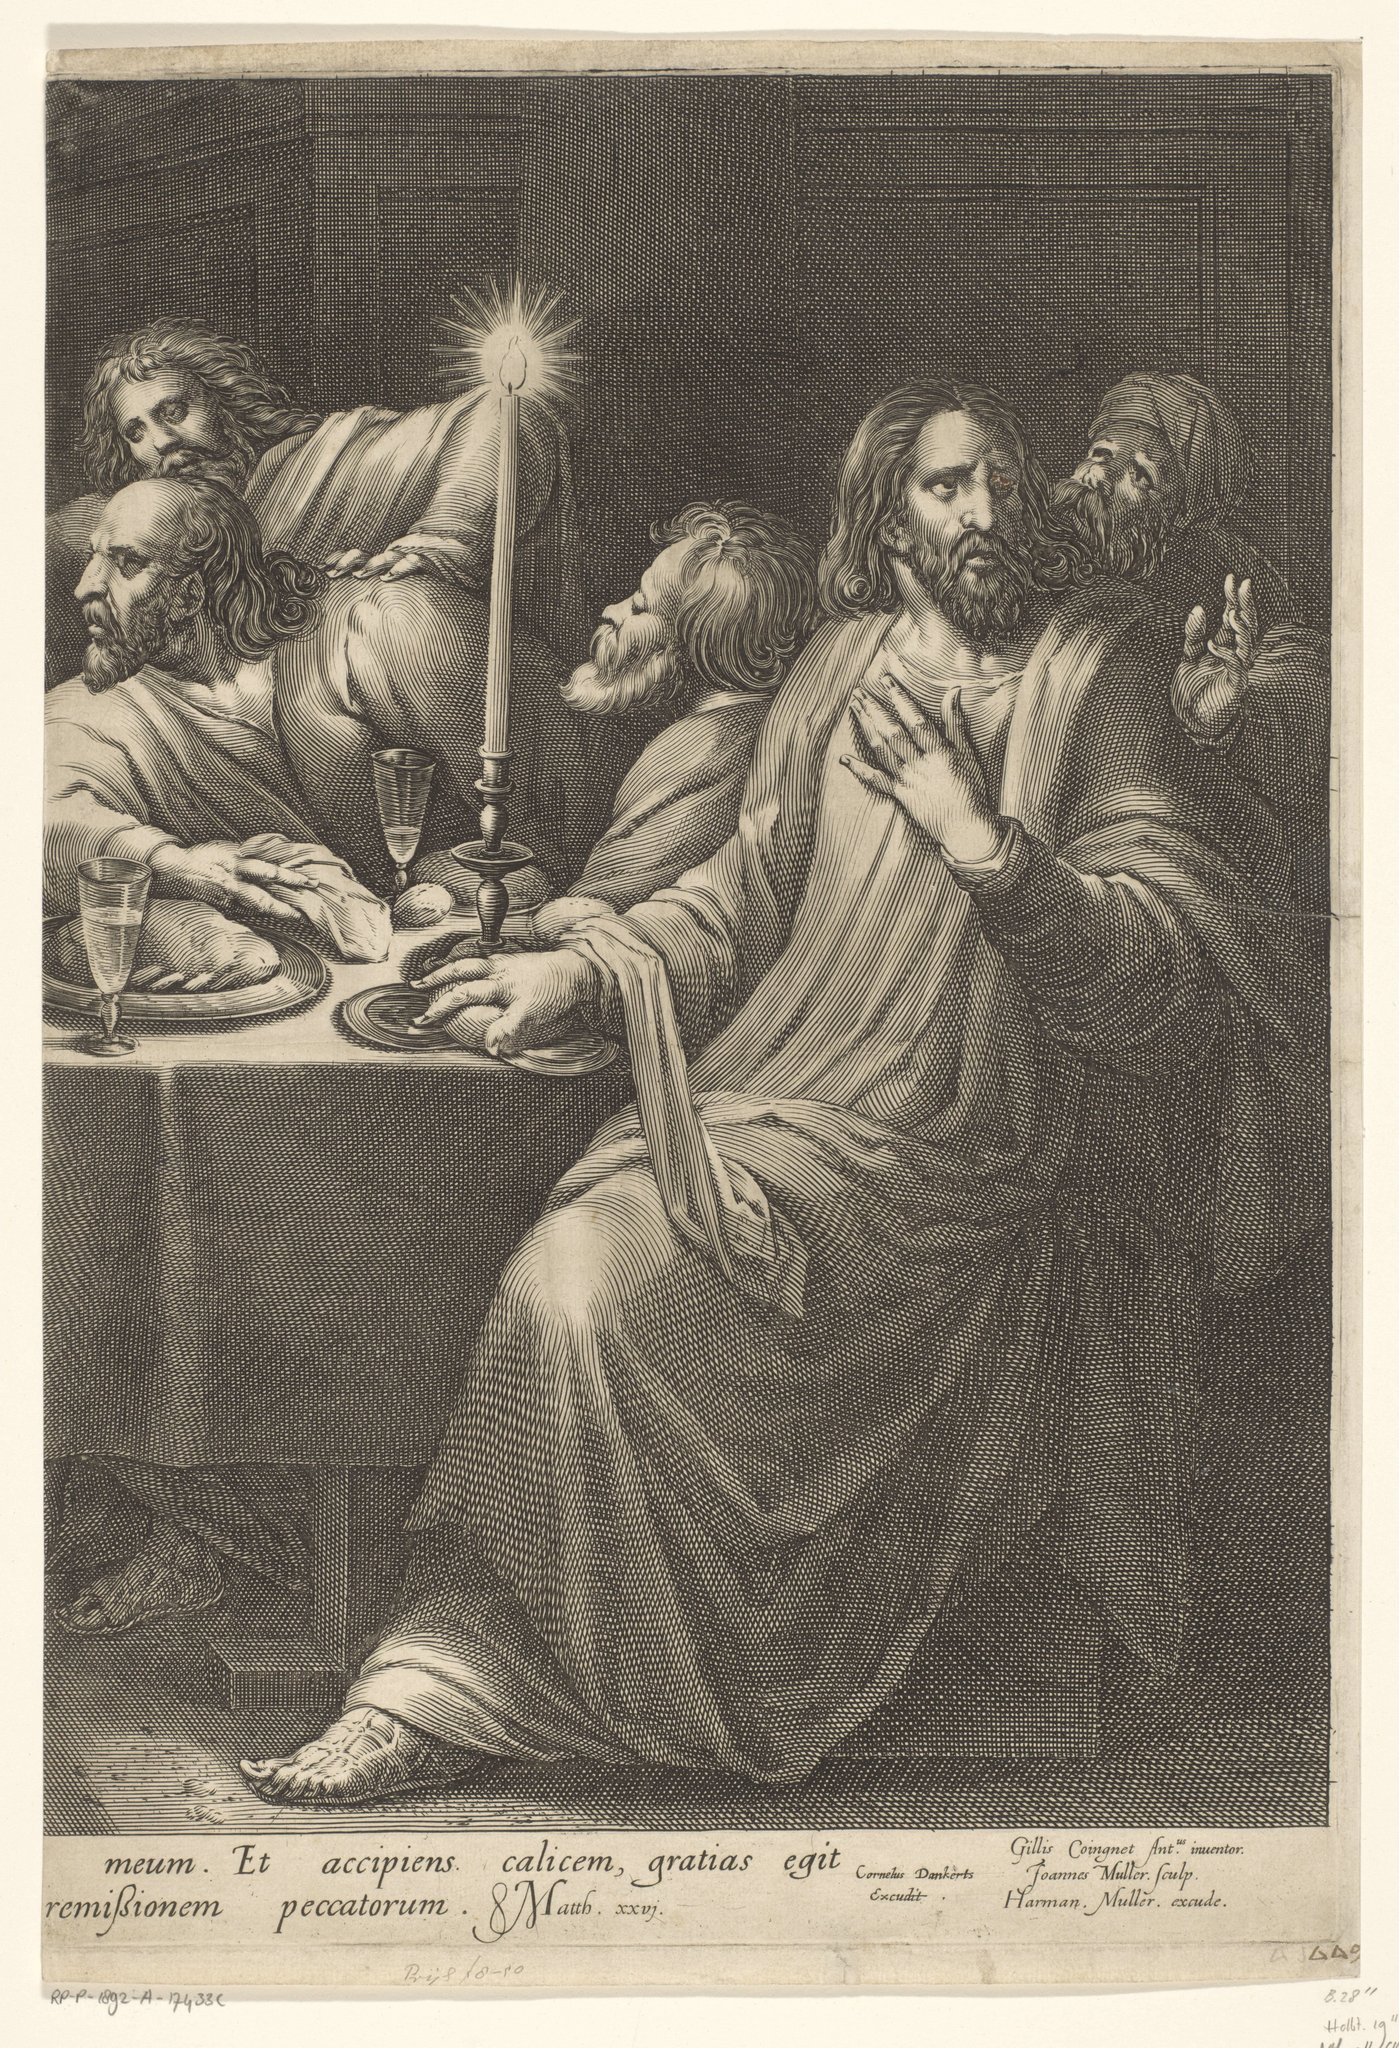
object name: print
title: Laatste avondmaal (rechter blad)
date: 1594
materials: paper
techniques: engraving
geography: amsterdam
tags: announcement of the betrayal of christ, and the reaction of the apostles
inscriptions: collector's mark: Lugt 2228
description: Vijf discipelen aan tafel bij het laatste avondmaal. Op tafel een brandende kaars, glazen een schaal met eten.